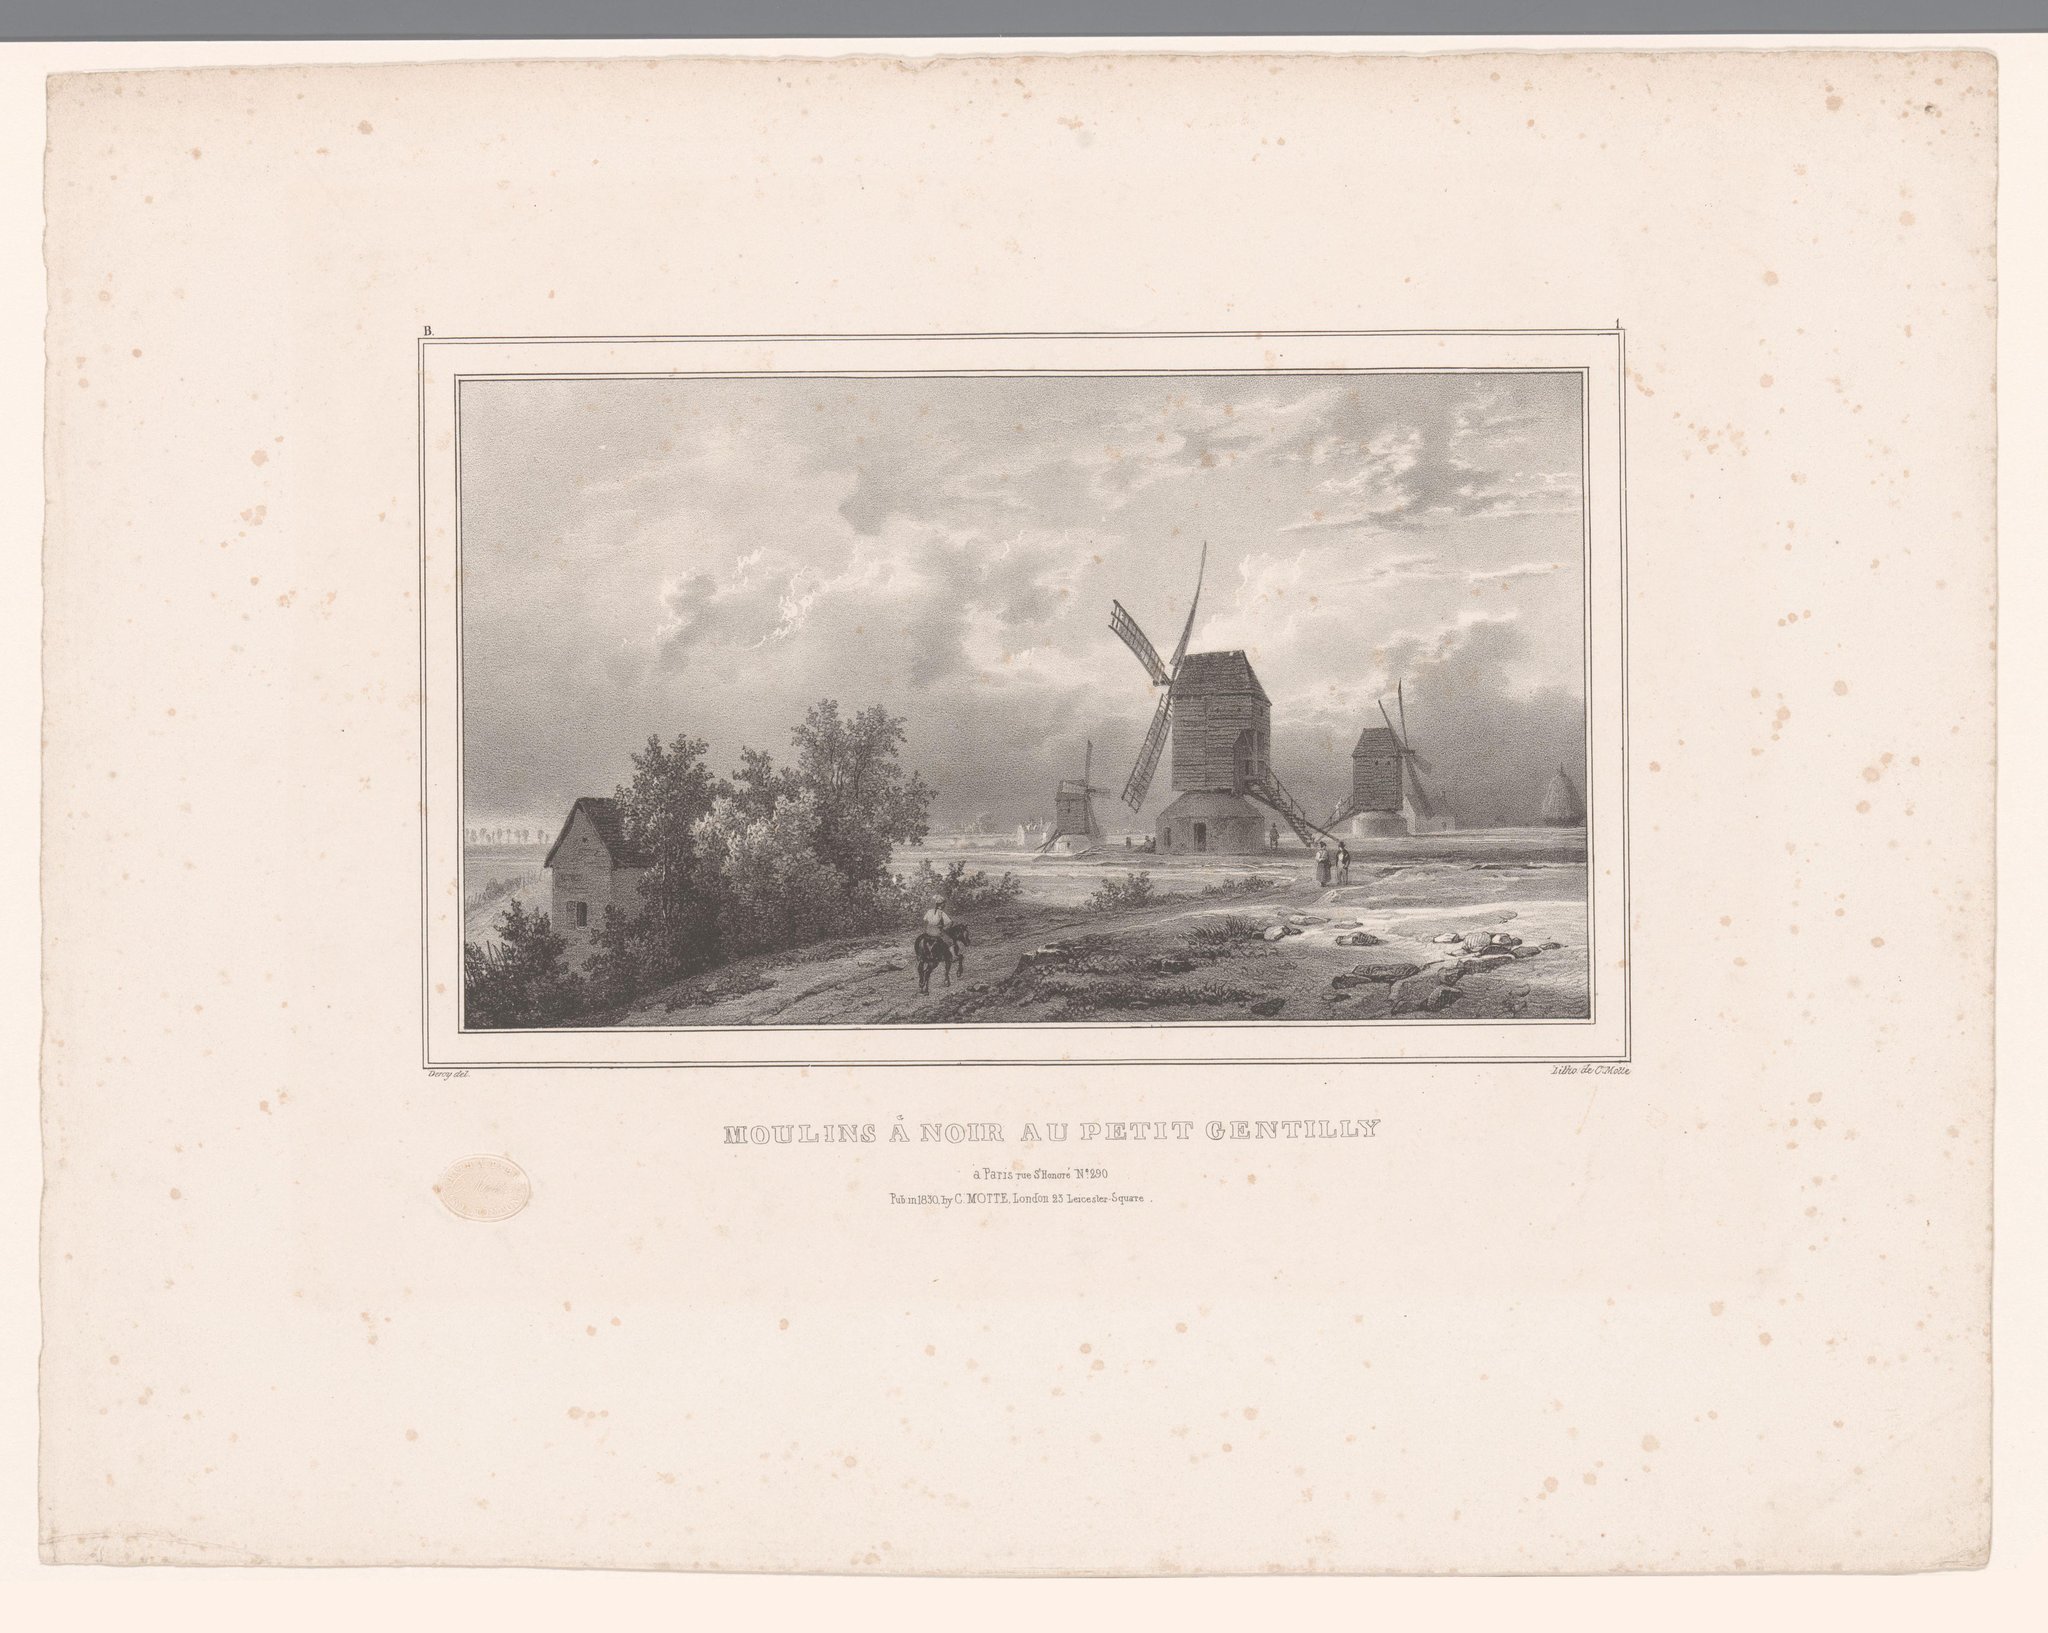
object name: print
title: Moulins à noir au Petit Gentilly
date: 1831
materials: paper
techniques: lithograph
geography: paris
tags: windmill in landscape (+ city(-scape) with figures, staffage)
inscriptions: collector's mark: Lugt 2228a, check stamp: Lugt 1828b